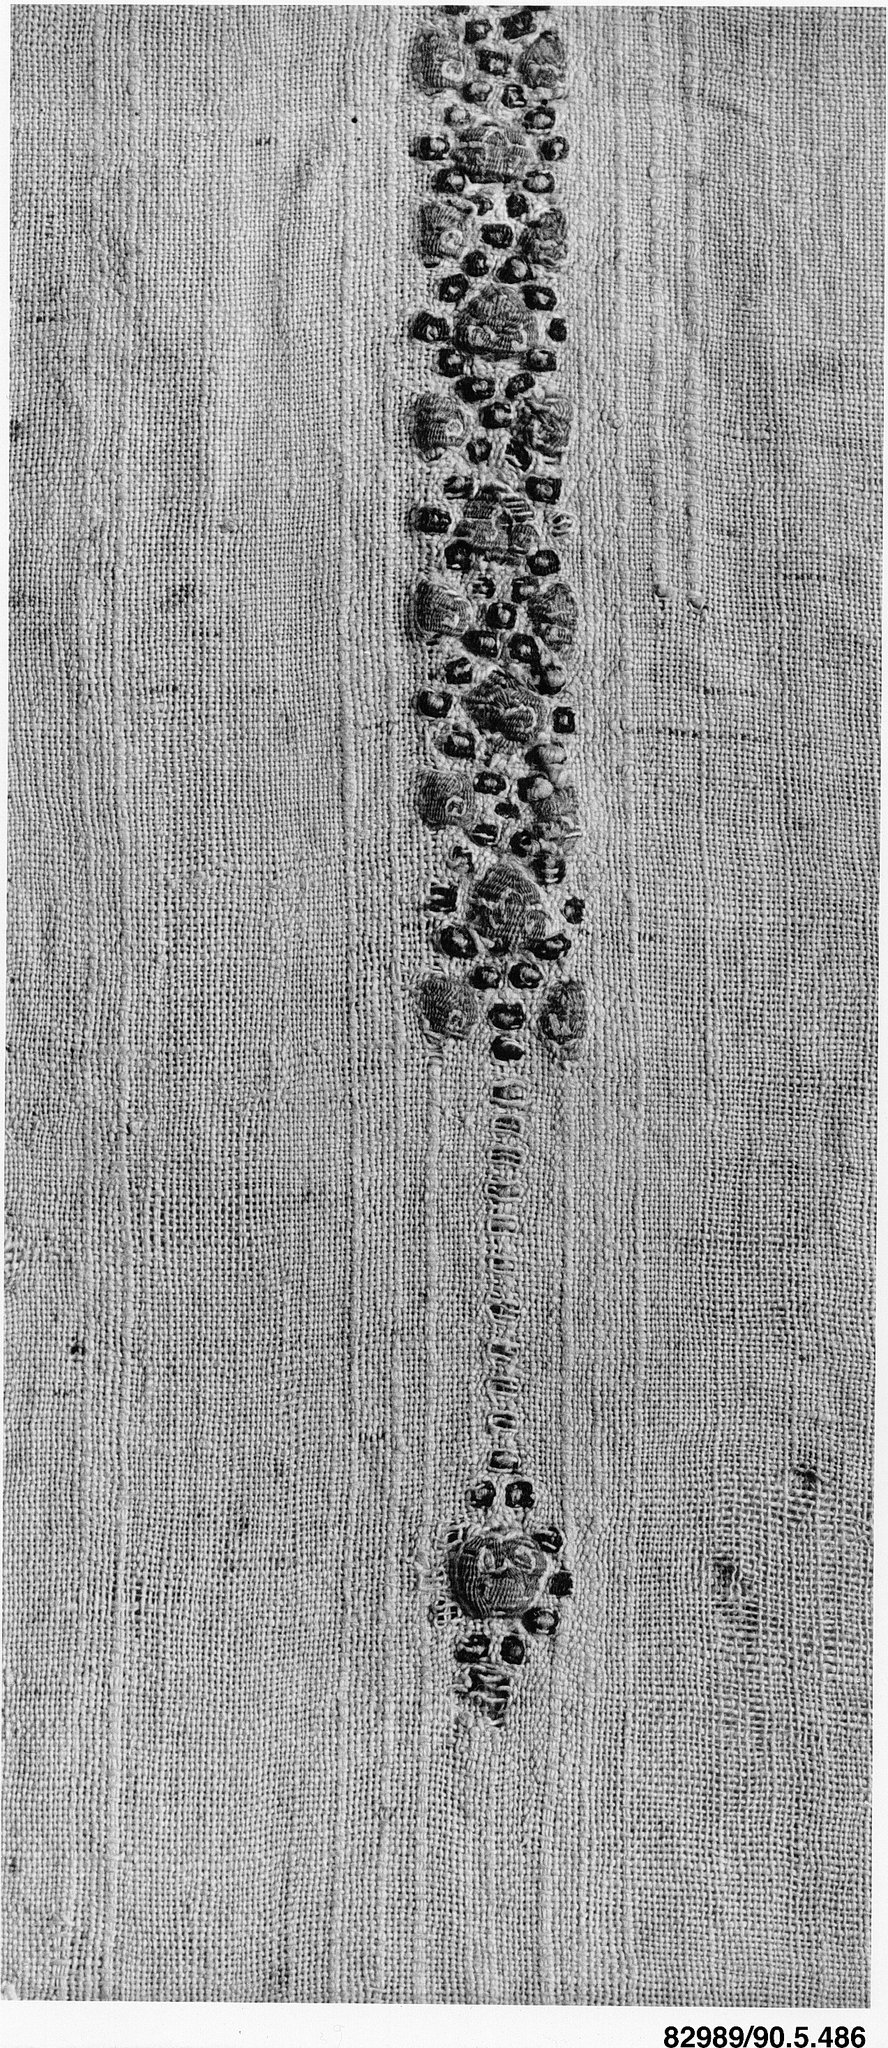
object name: textile fragment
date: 401-500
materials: linen, wool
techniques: weave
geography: egypt